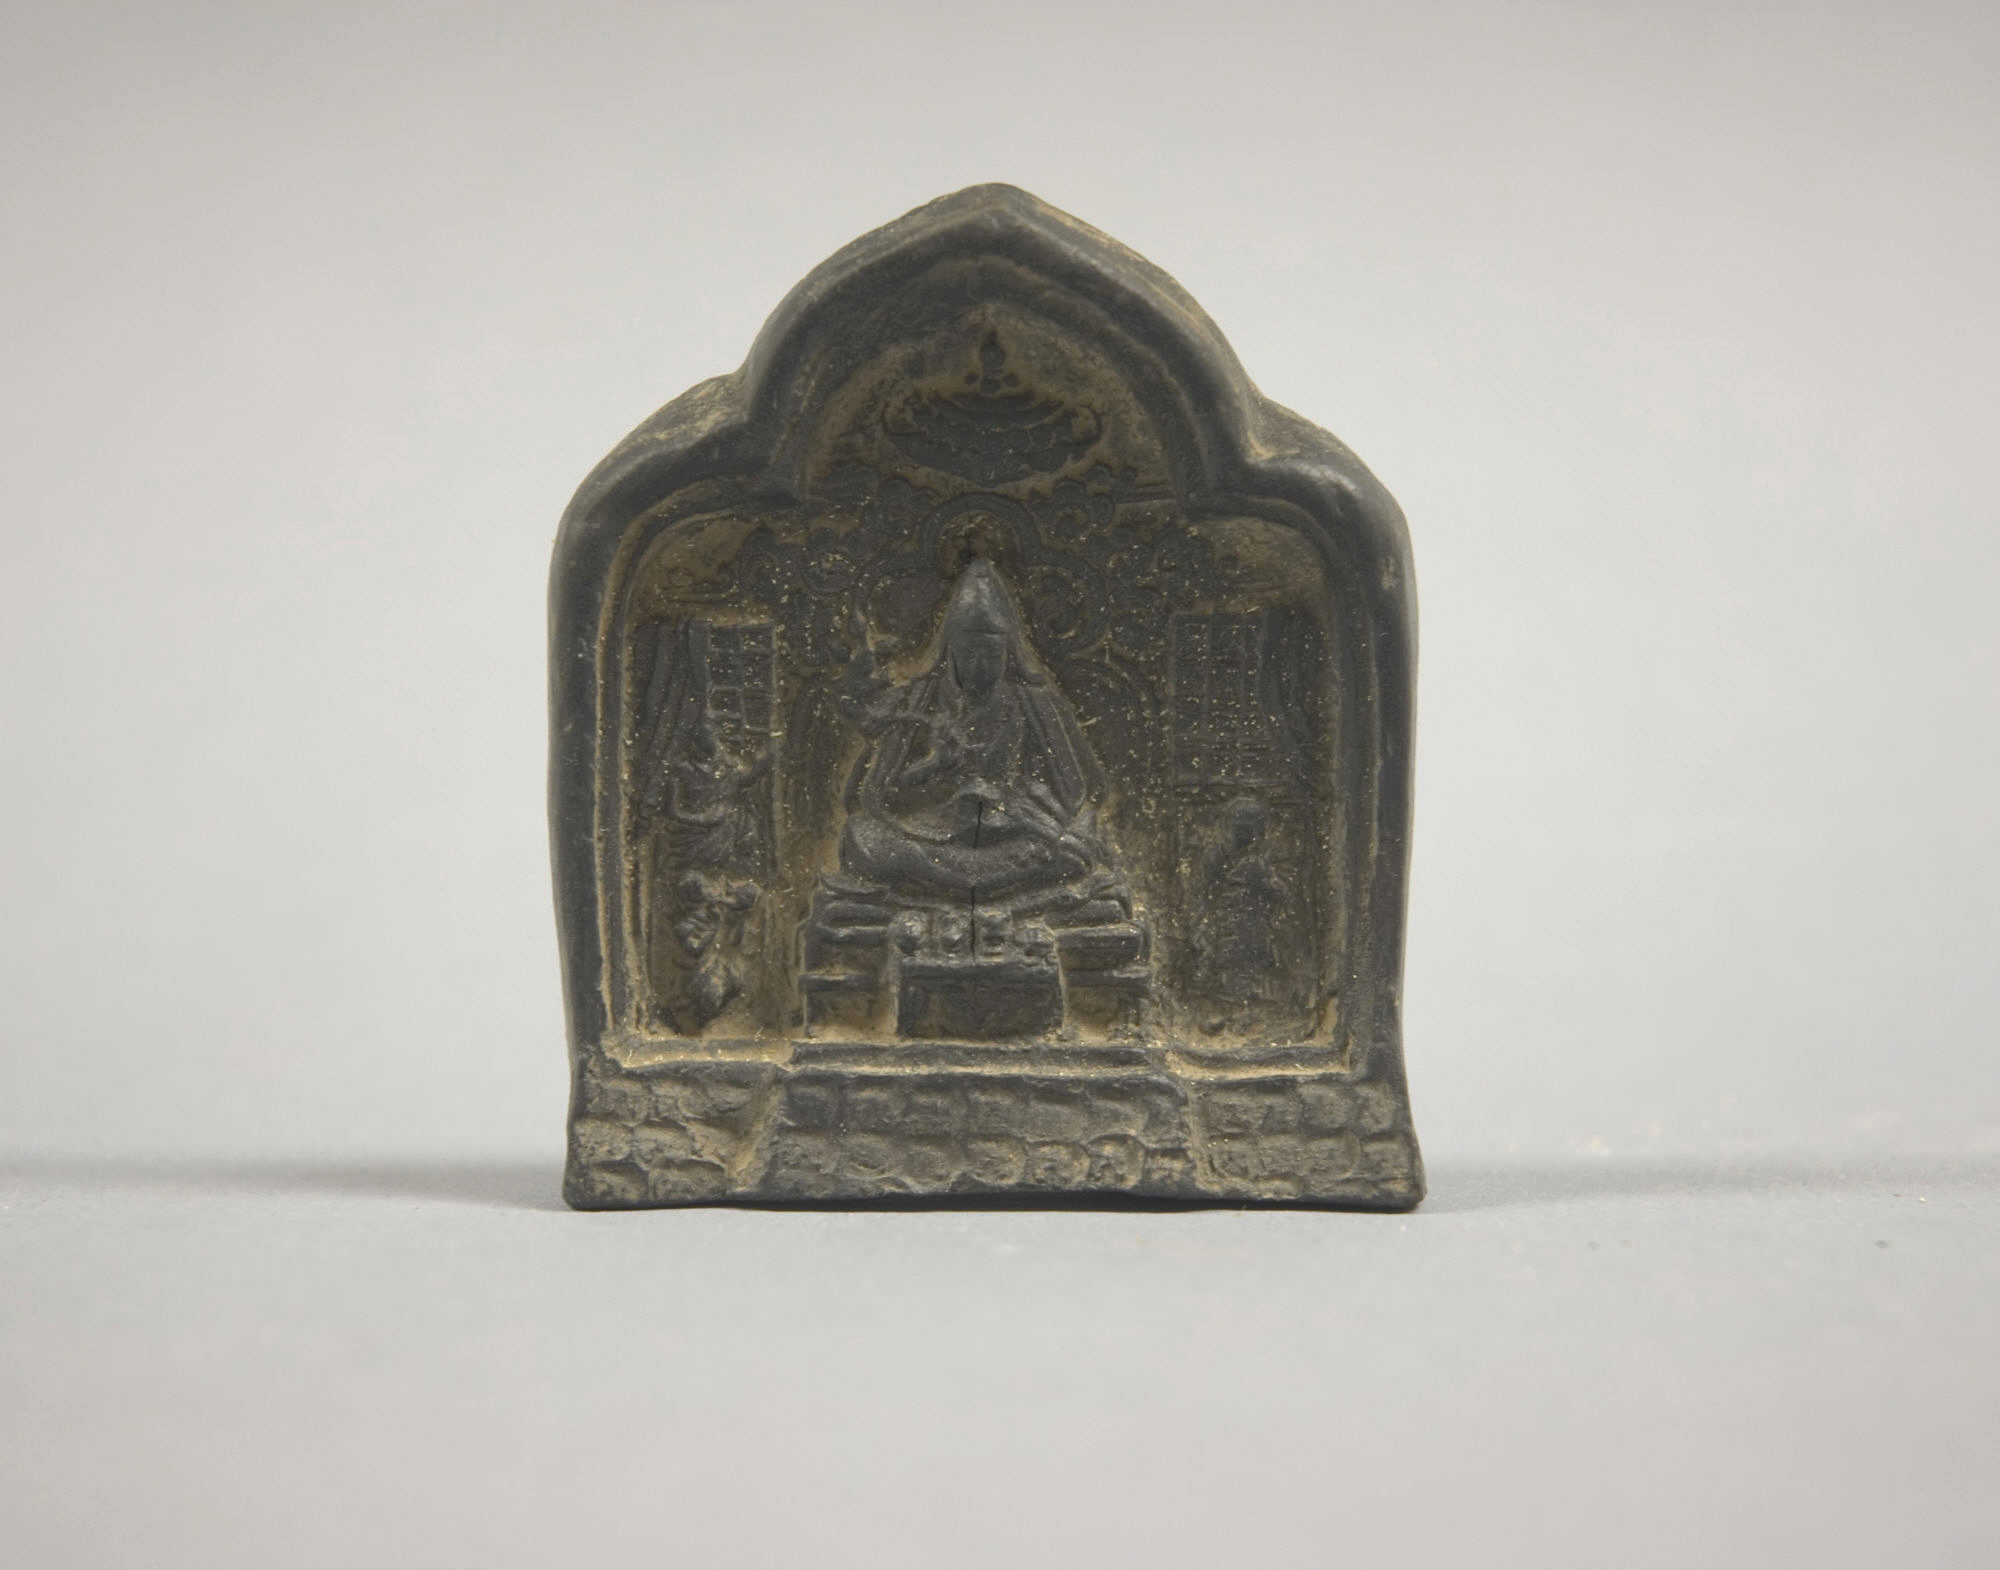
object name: votive plaque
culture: tibetan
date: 701-800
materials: clay